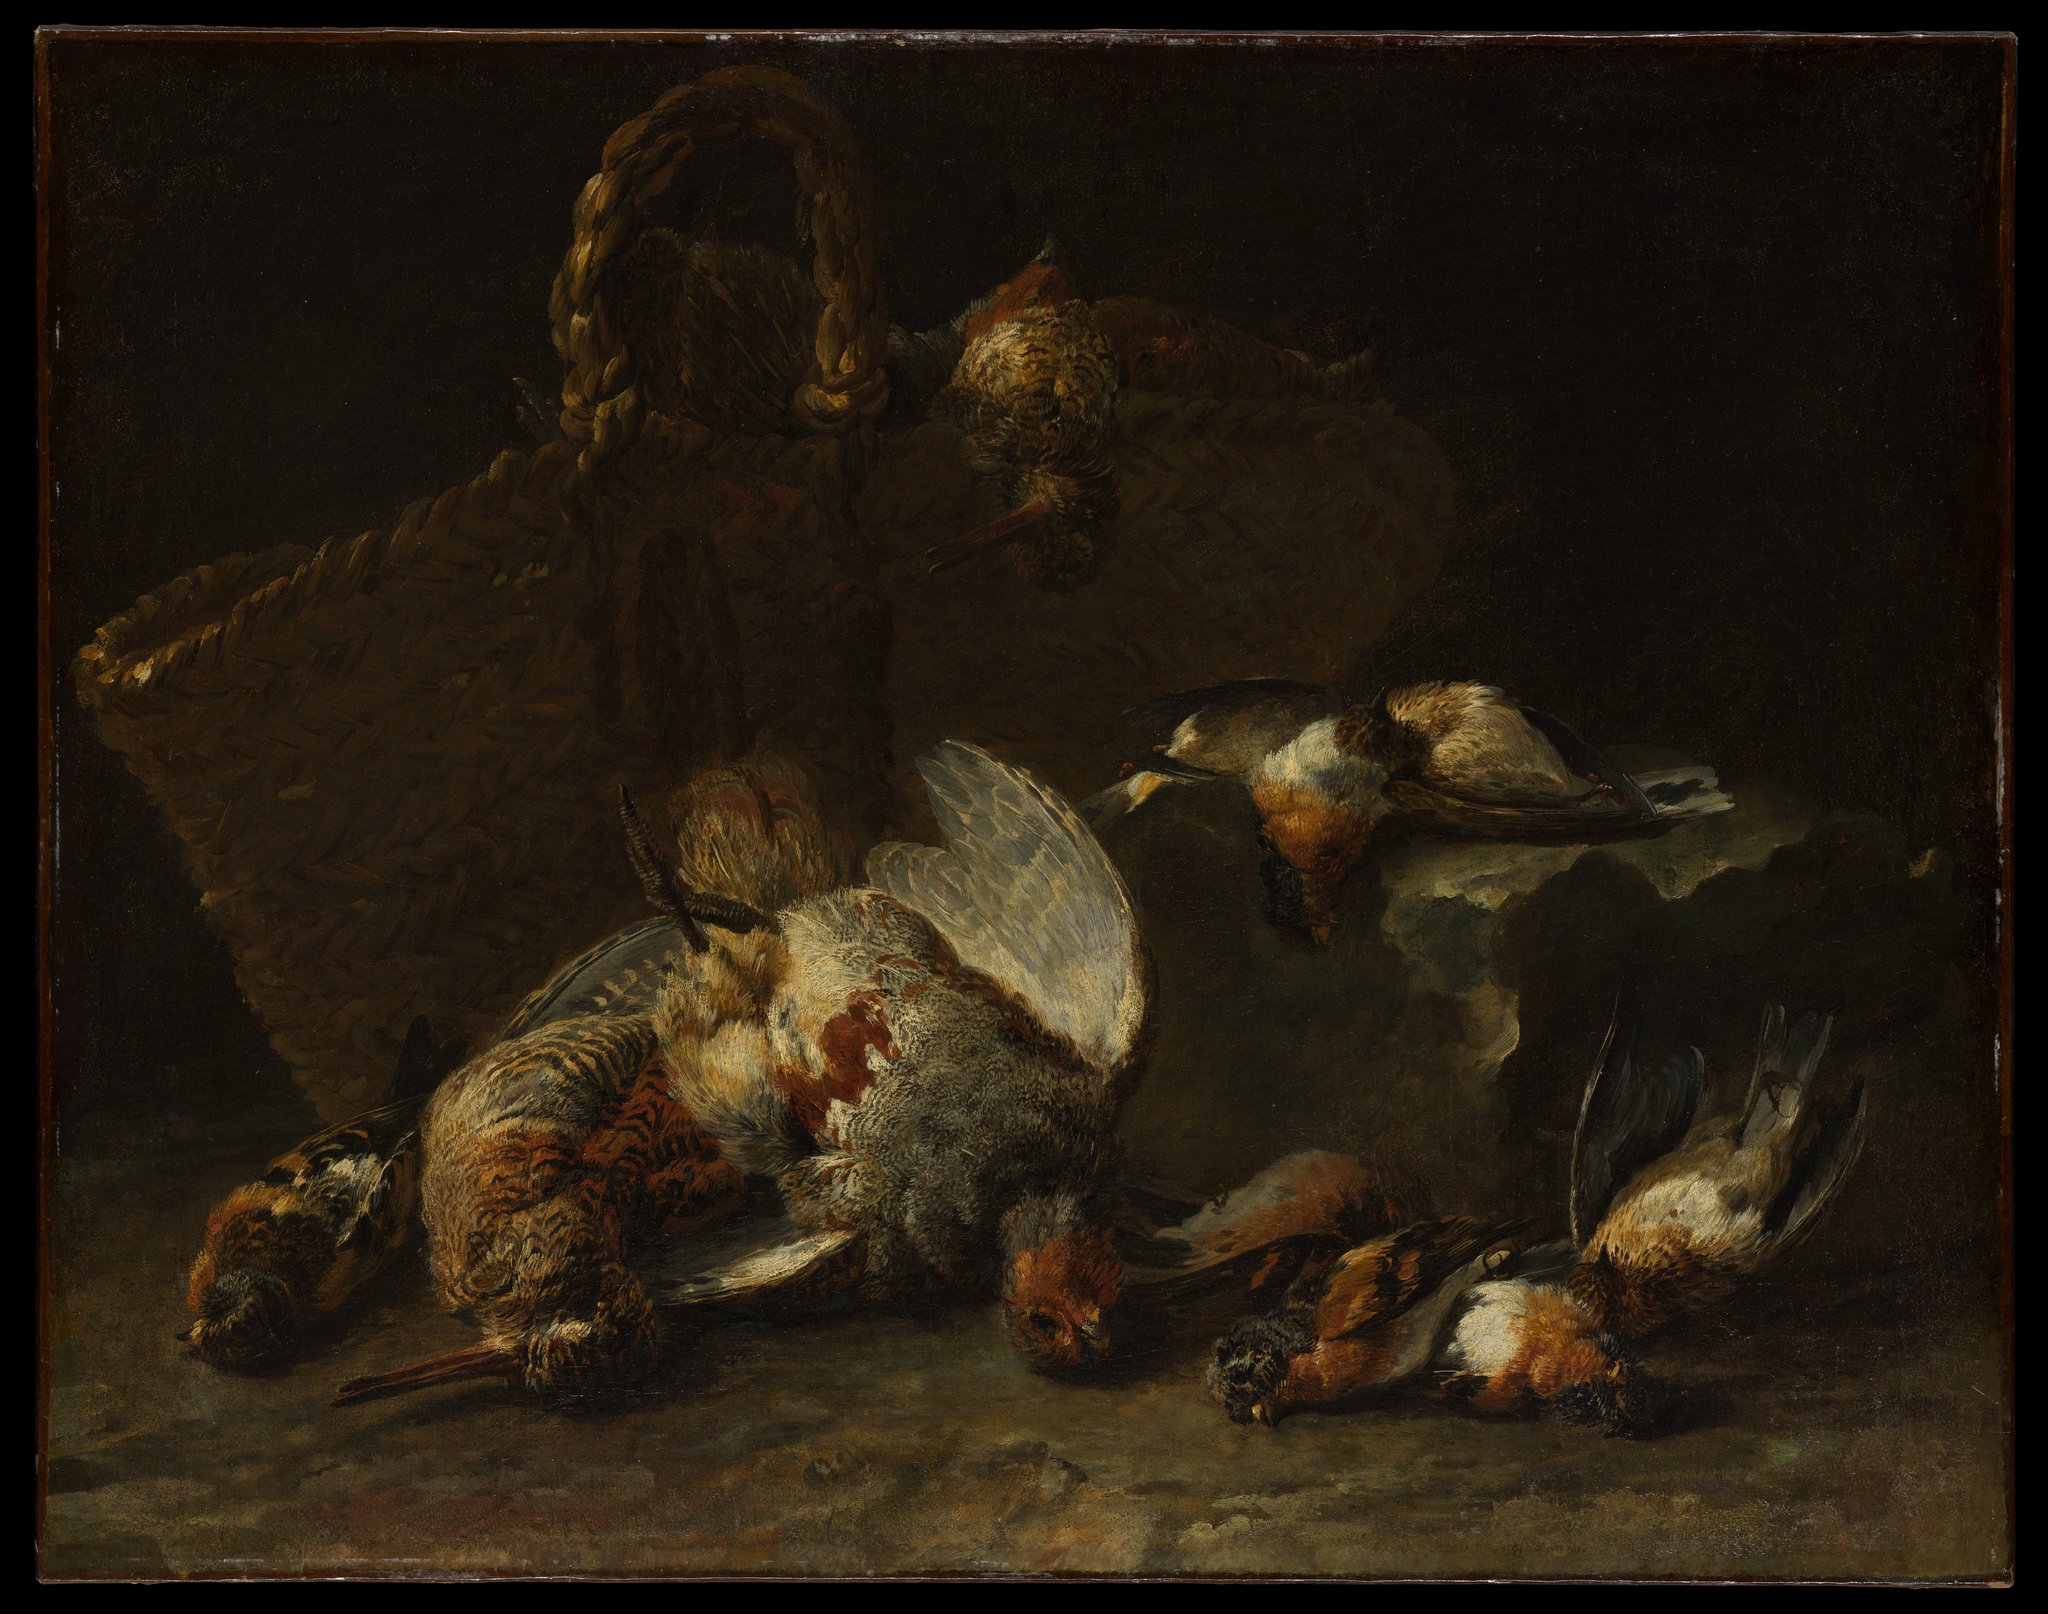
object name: painting, overdoor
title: A Basket and Birds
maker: jan fyt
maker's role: artist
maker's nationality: flemish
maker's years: 1611-1661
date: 1631-1661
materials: canvas, oil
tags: birds,still life,baskets